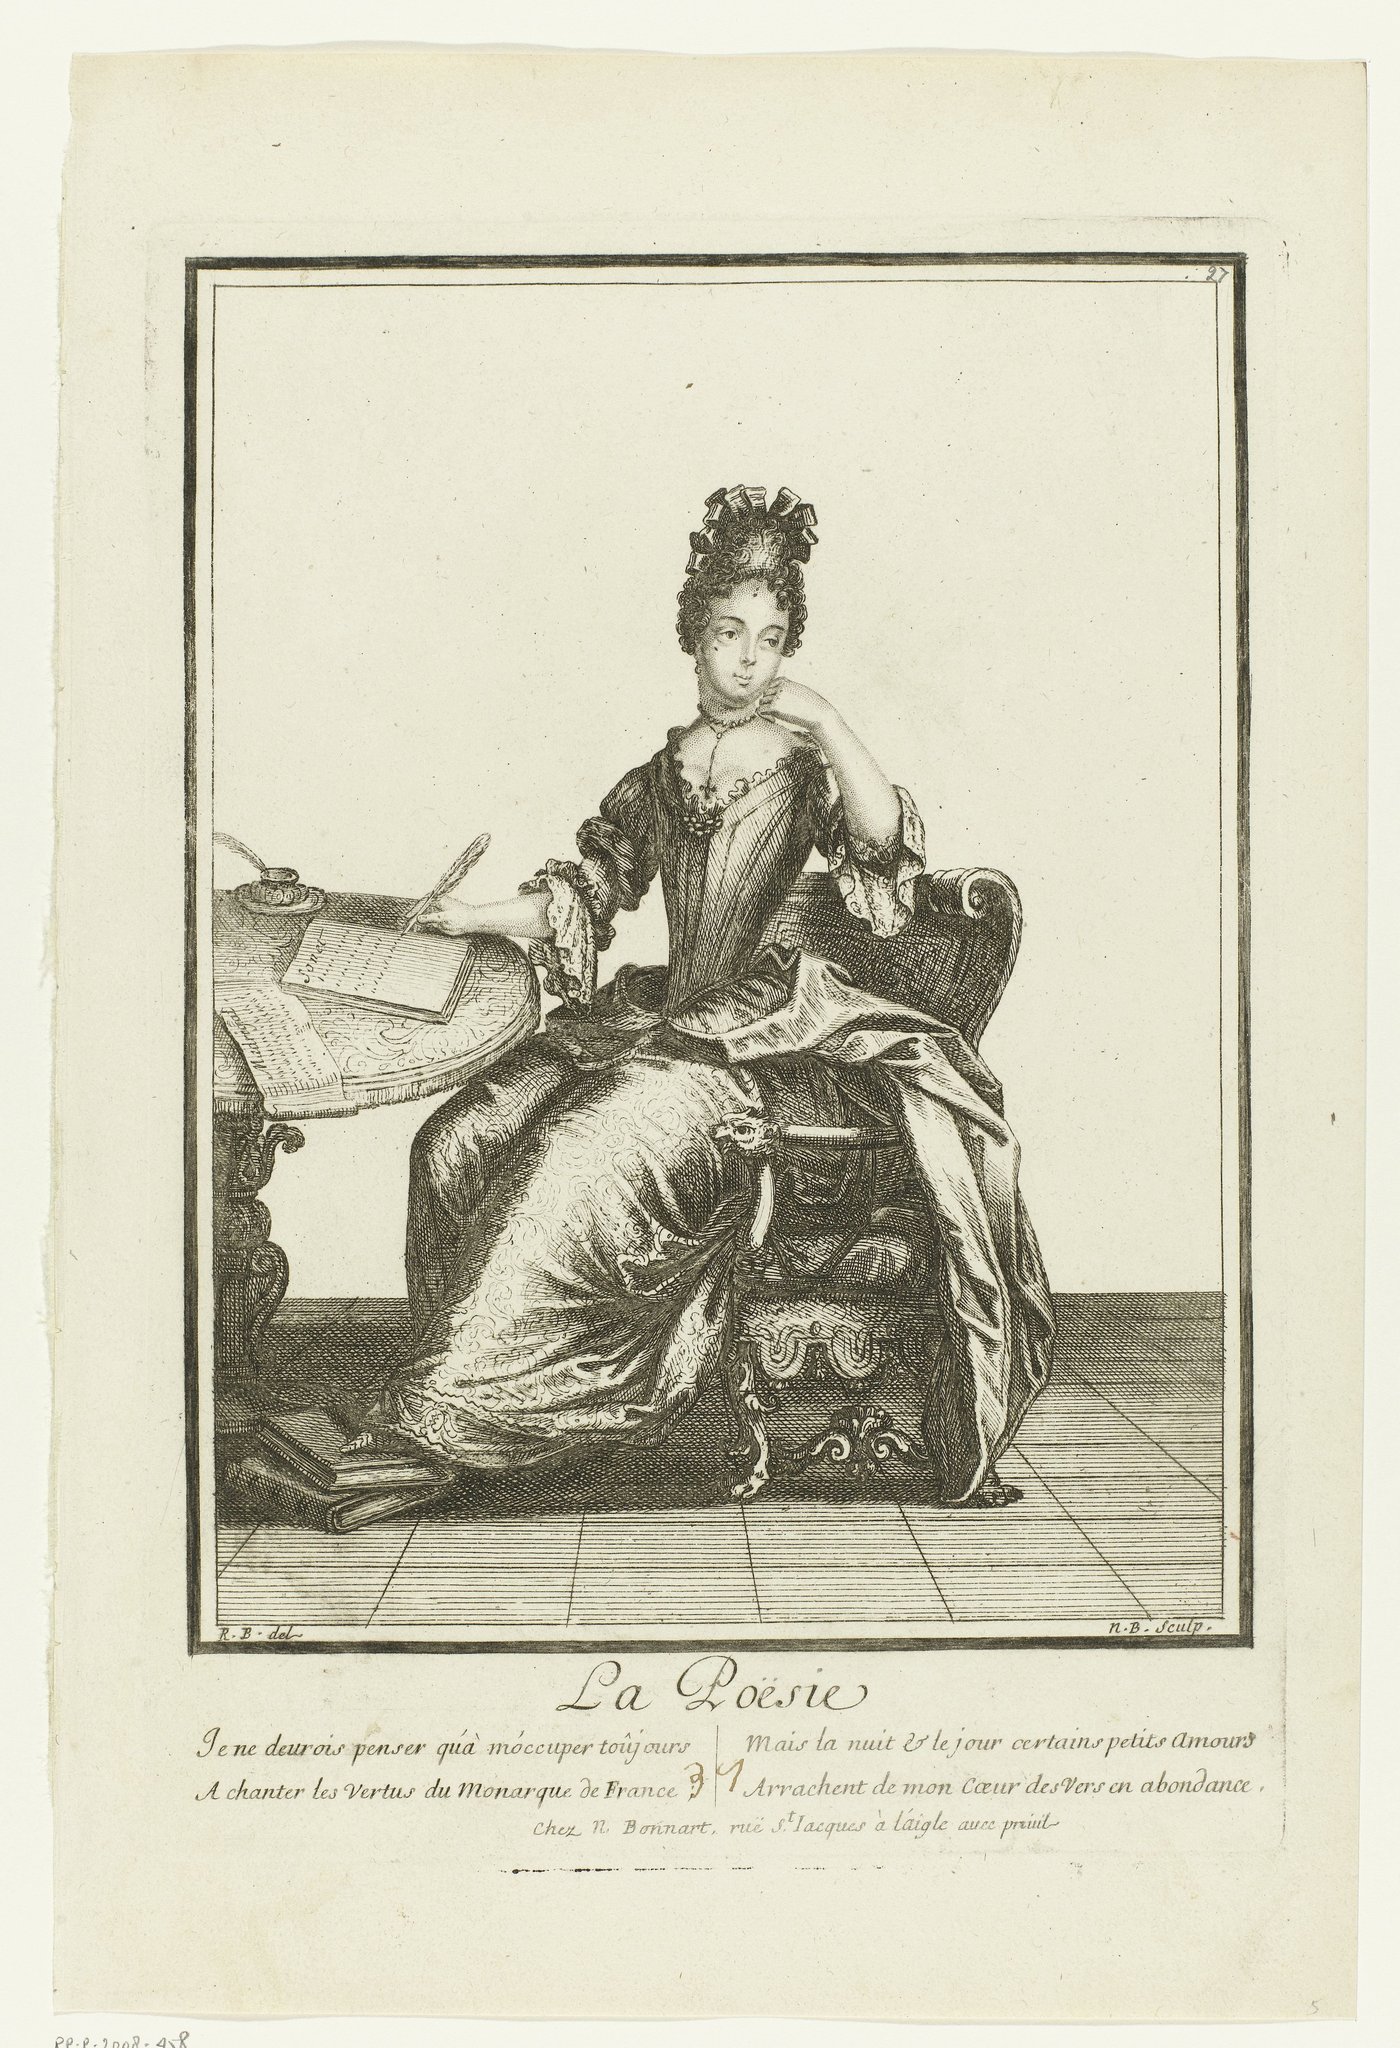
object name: print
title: La Poësie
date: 1647-1718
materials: paper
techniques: engraving, etching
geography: france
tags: ink-well, symbolic representations, allegories and emblems ~ poetry; 'poesia' (ripa)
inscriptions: collector's mark: Lugt 2228, collector's mark: Lugt 2760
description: Vrouw in een leunstoel, schrijfveer in de hand, met haar linkerarm onder haar kin, zittend achter een ronde tafel waarop papier en inktpot.